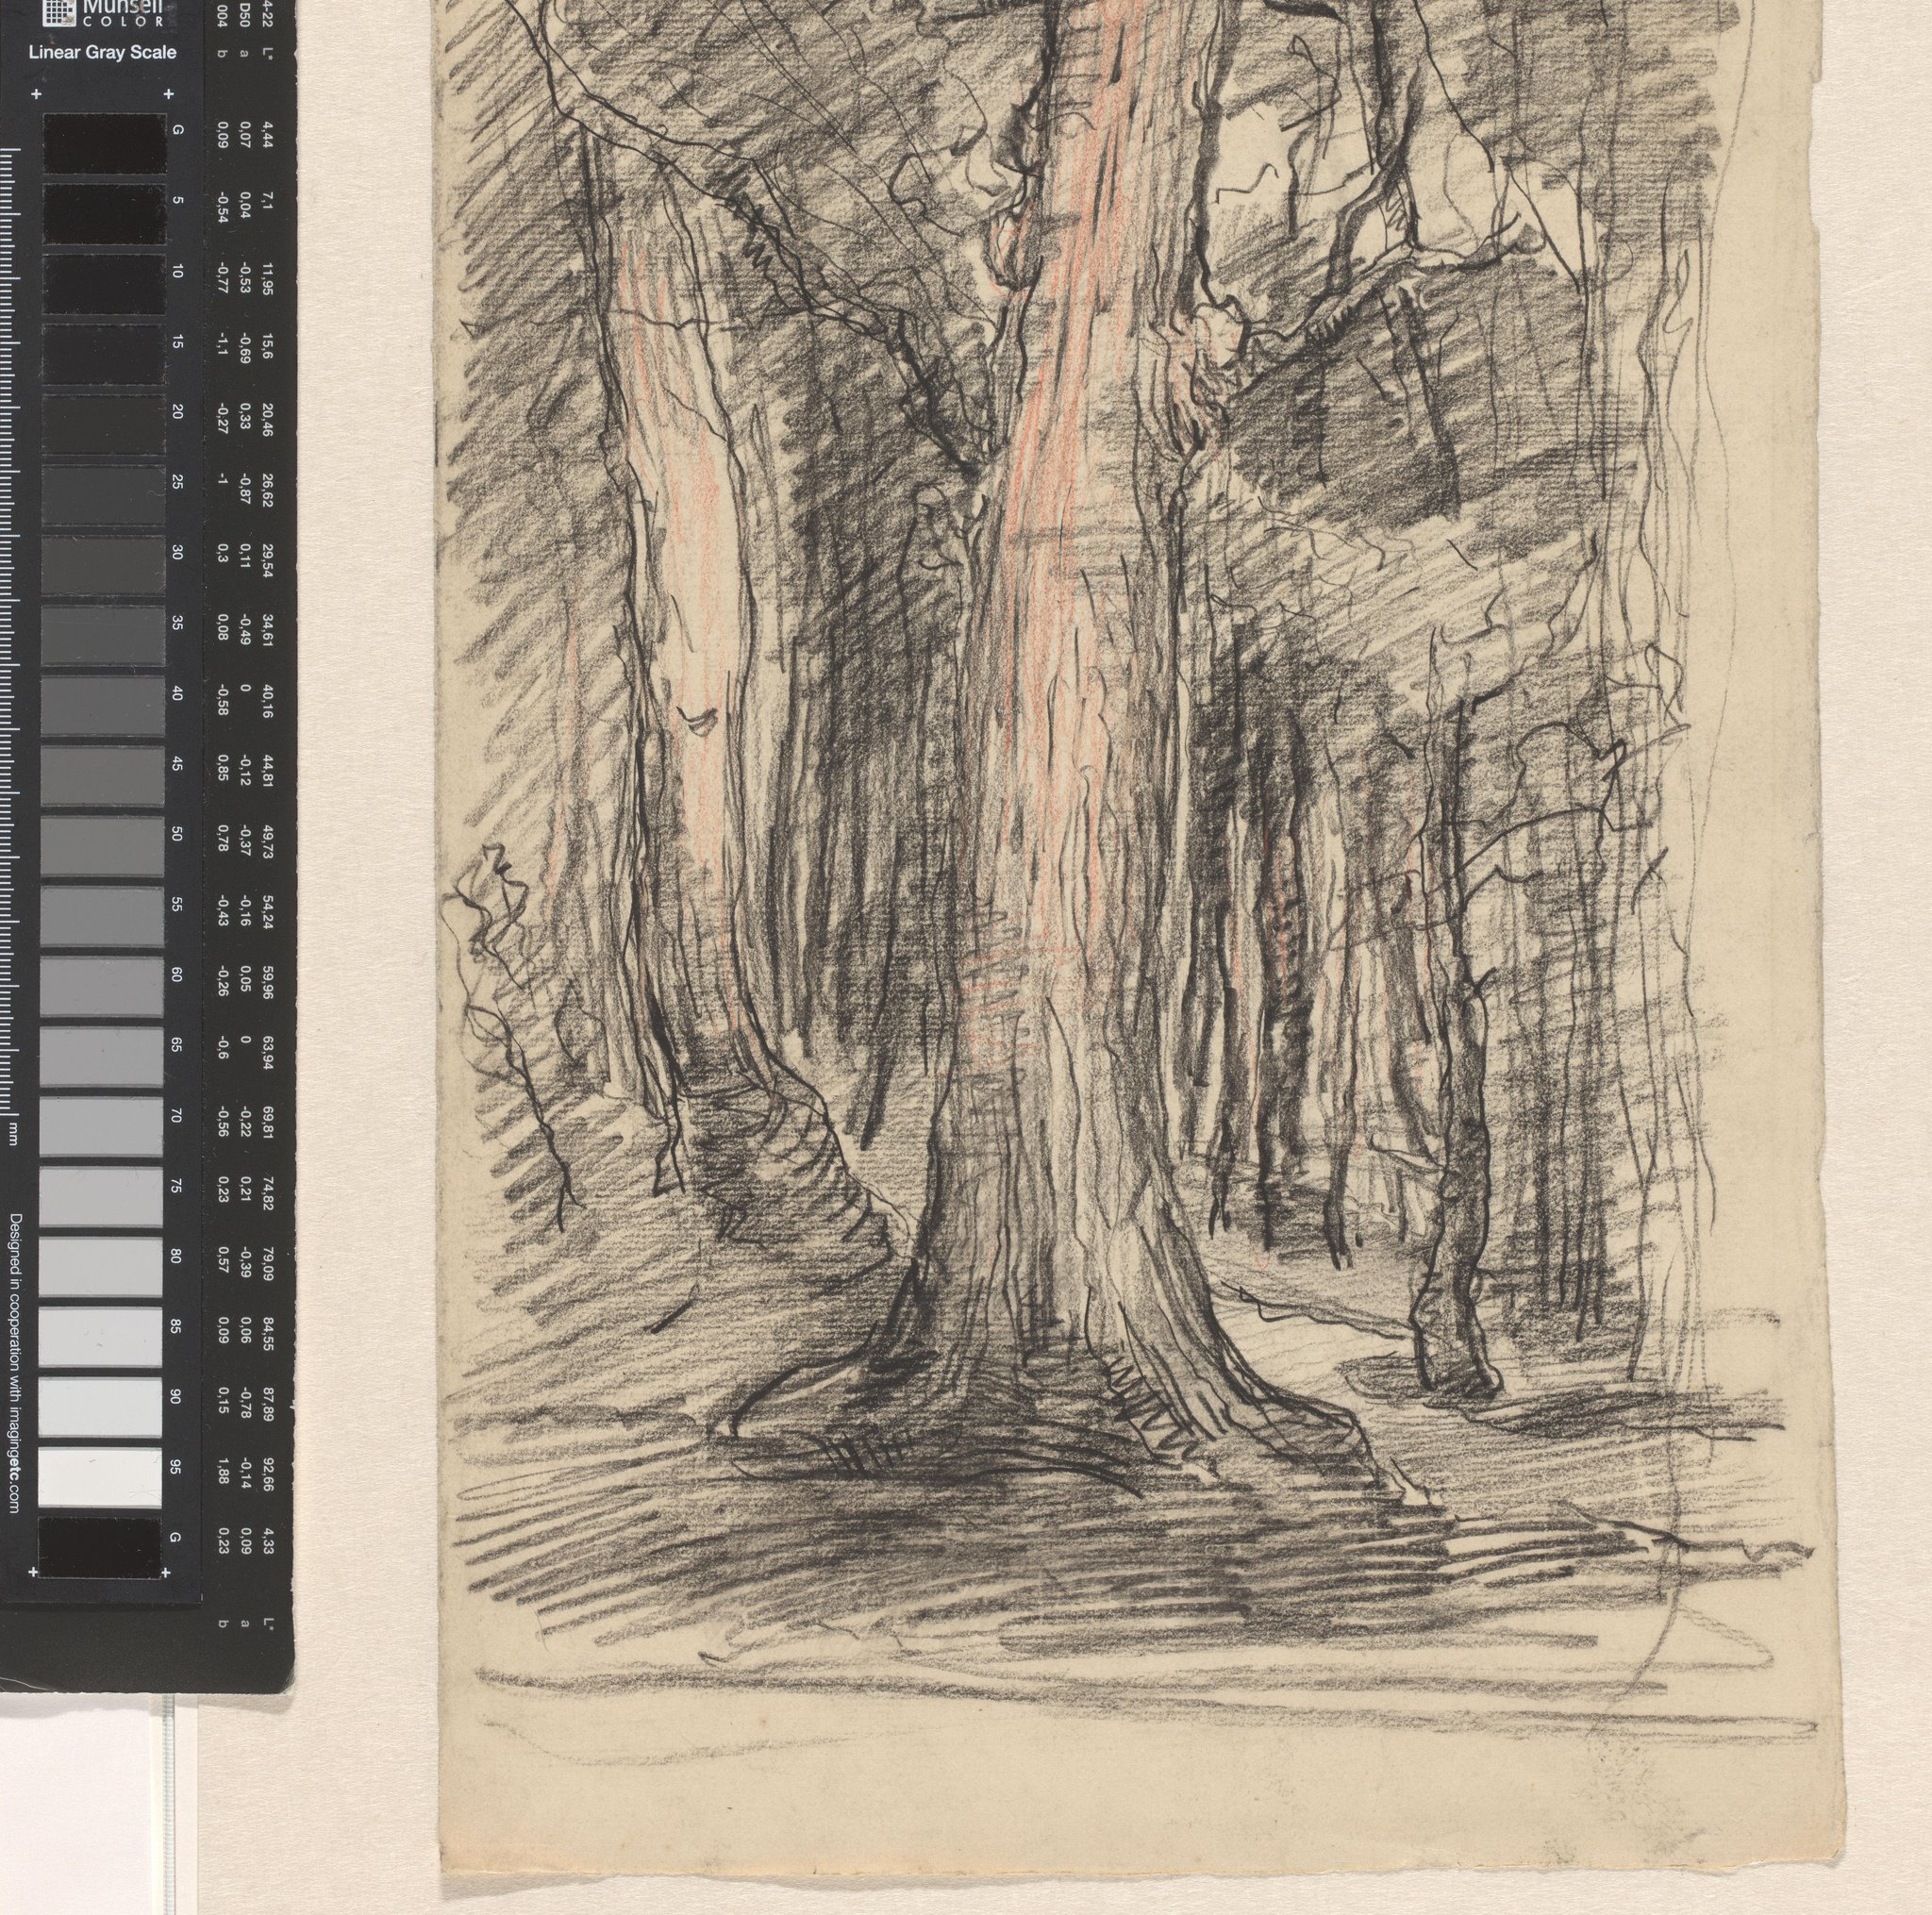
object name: drawing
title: Bomen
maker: sientje mesdag-van houten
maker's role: draughtsman, painter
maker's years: 1834-1909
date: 1880-1909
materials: chalk, paper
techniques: drawing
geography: netherlands